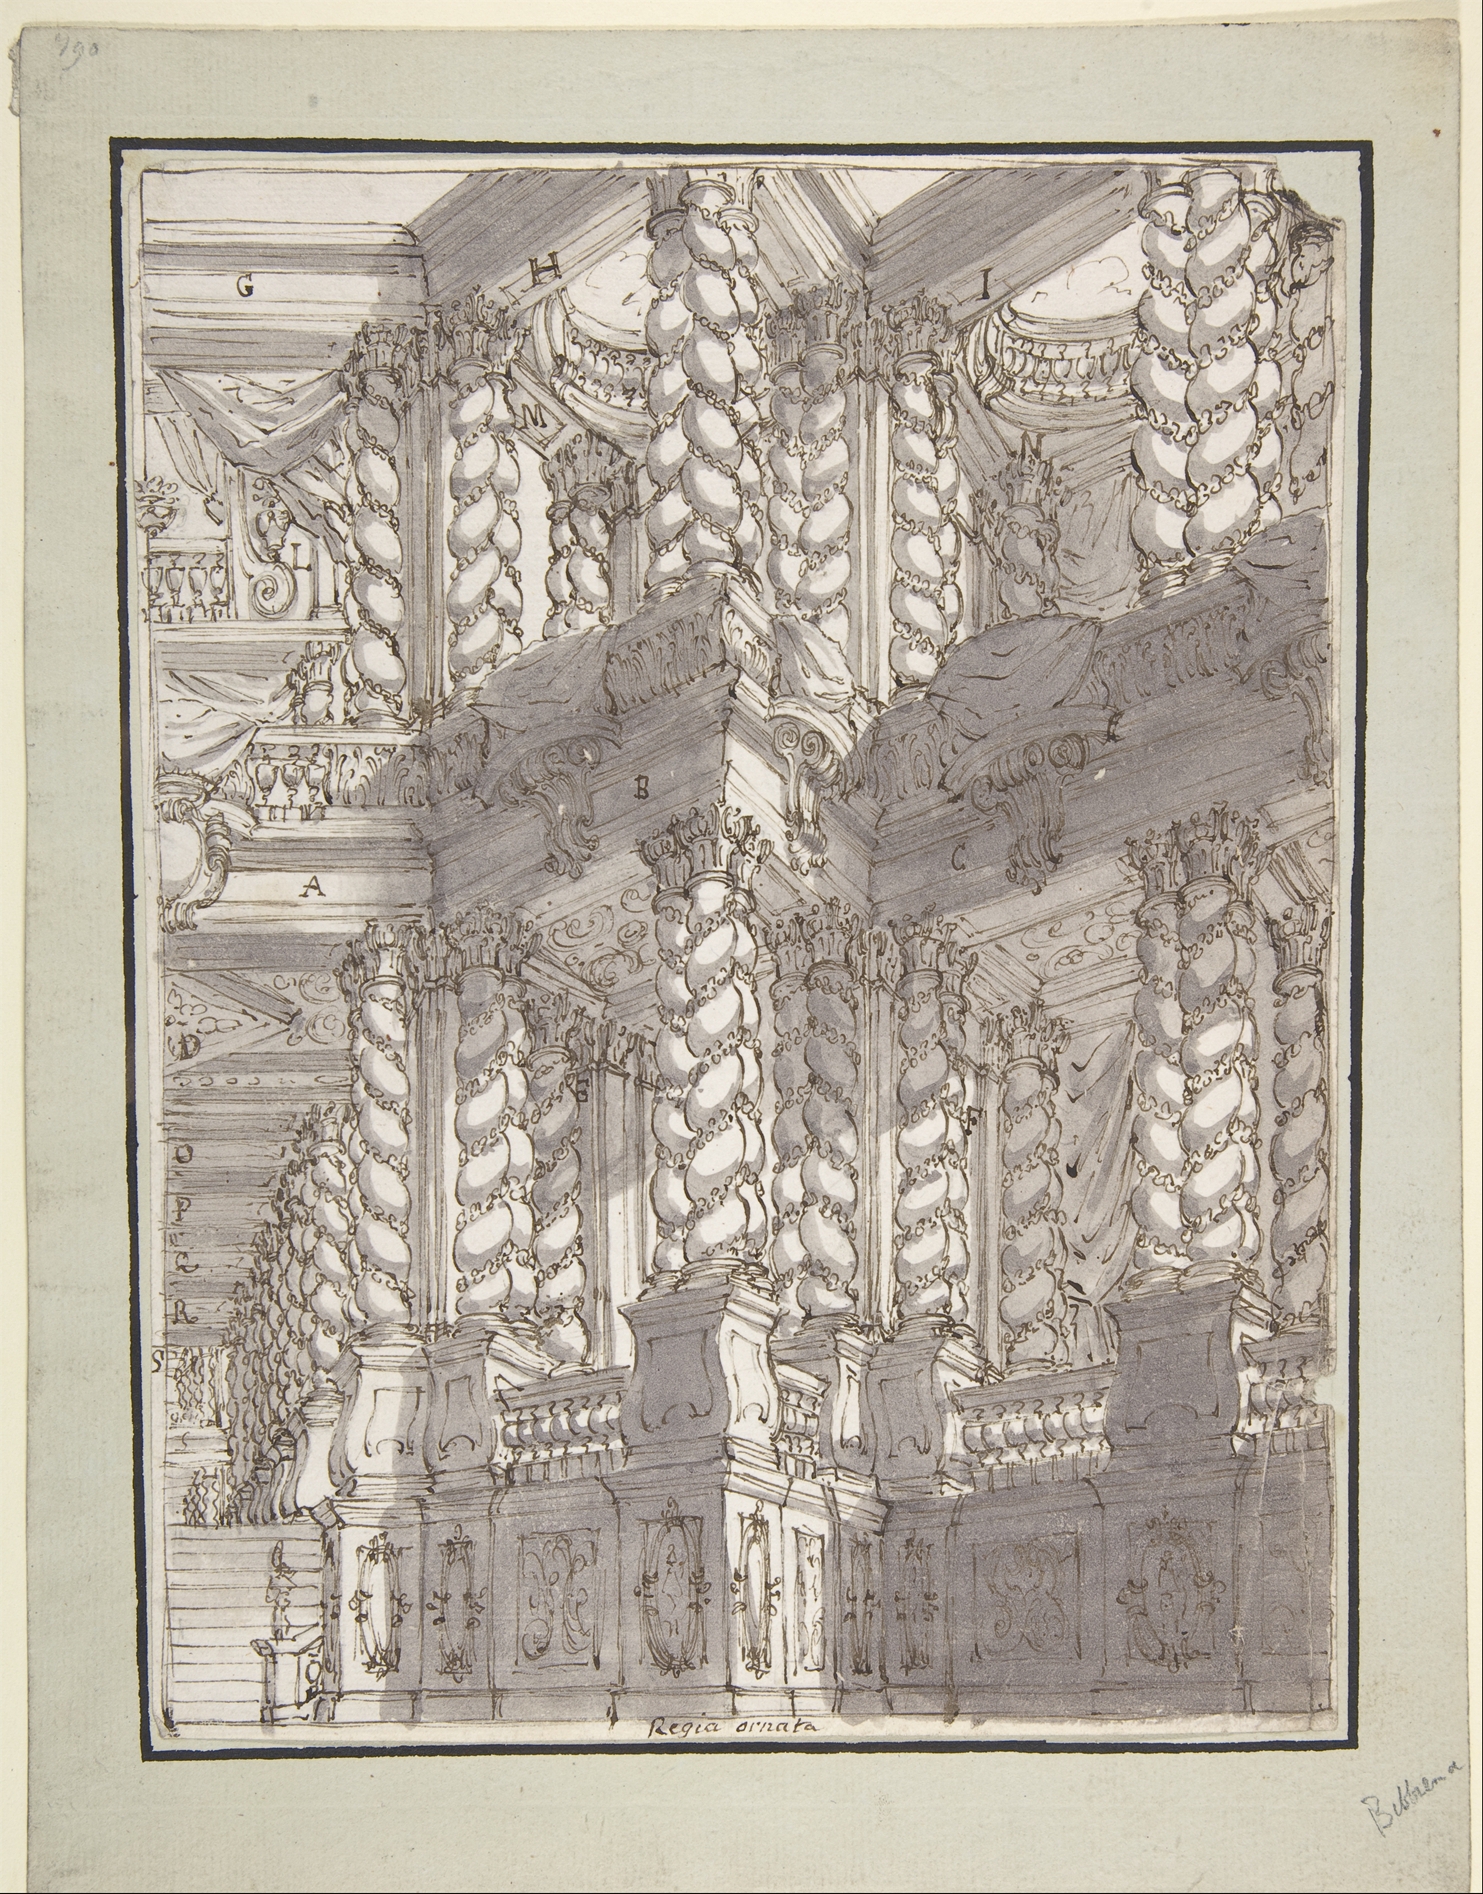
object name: drawing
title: Design for Stage Set with Double Storey of Torqued Columns and Balustrades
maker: francesco galli bibiena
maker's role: artist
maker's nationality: italian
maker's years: 1659-1739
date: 1659-1739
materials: graphite, ink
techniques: brush, pen, wash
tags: columns,interiors,stage design